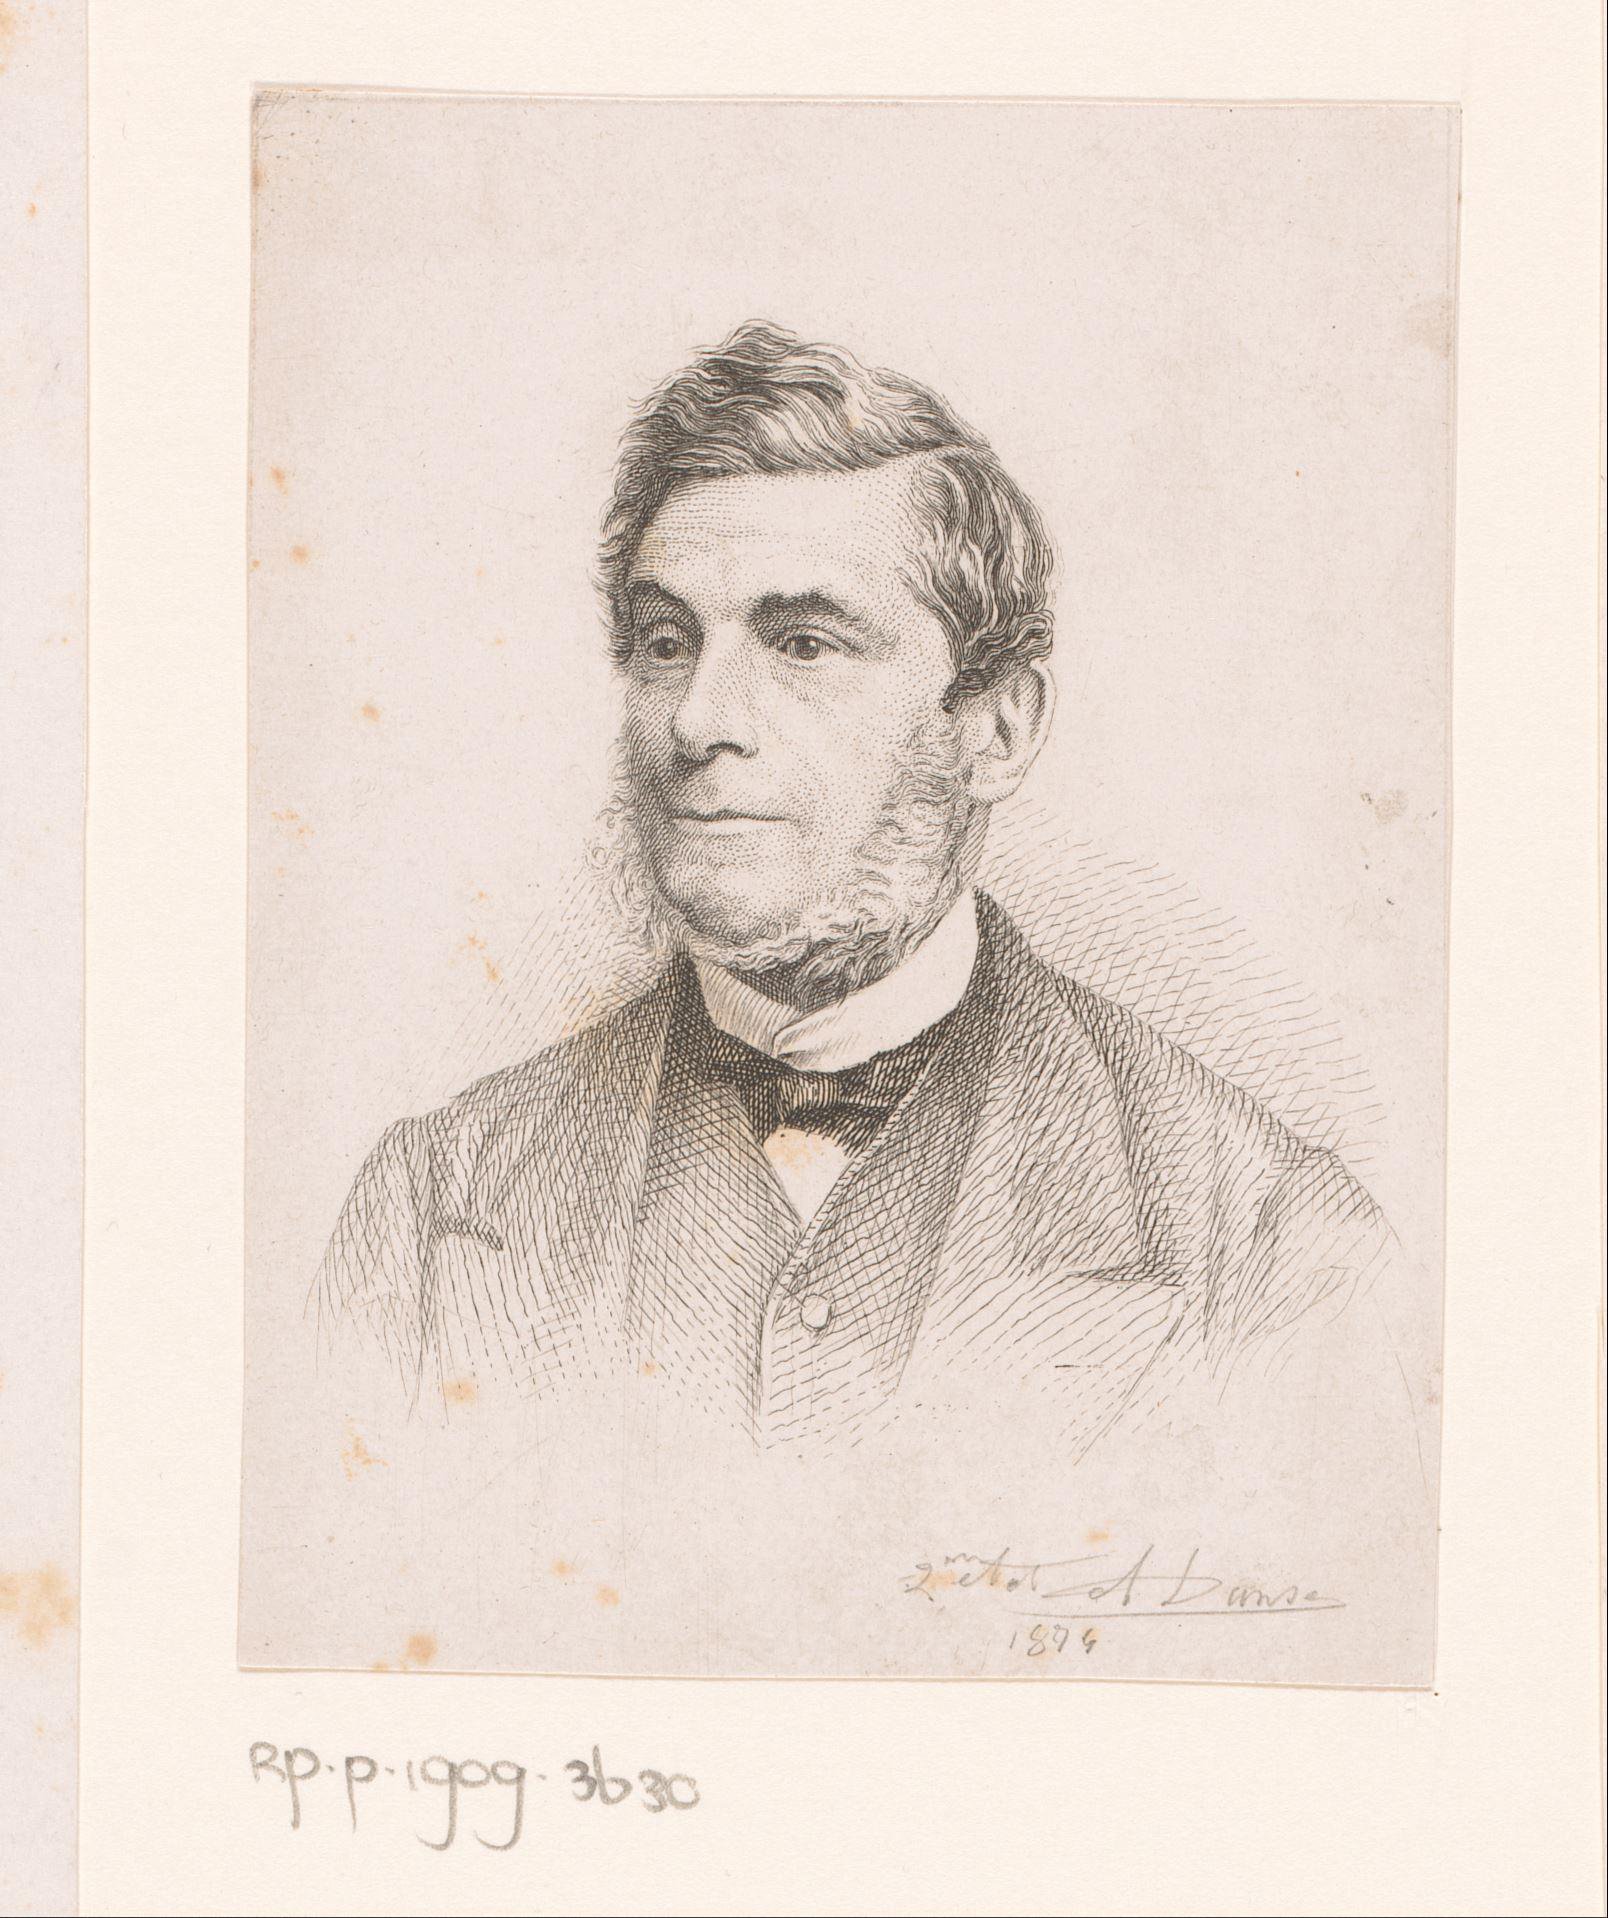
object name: print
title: Portret van de heer Poelman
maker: auguste danse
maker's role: print maker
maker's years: 1829-1929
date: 1874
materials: paper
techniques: etching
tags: anonymous historical person portrayed alone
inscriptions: annotation: ‘2me etat’, collector's mark: Lugt 2228